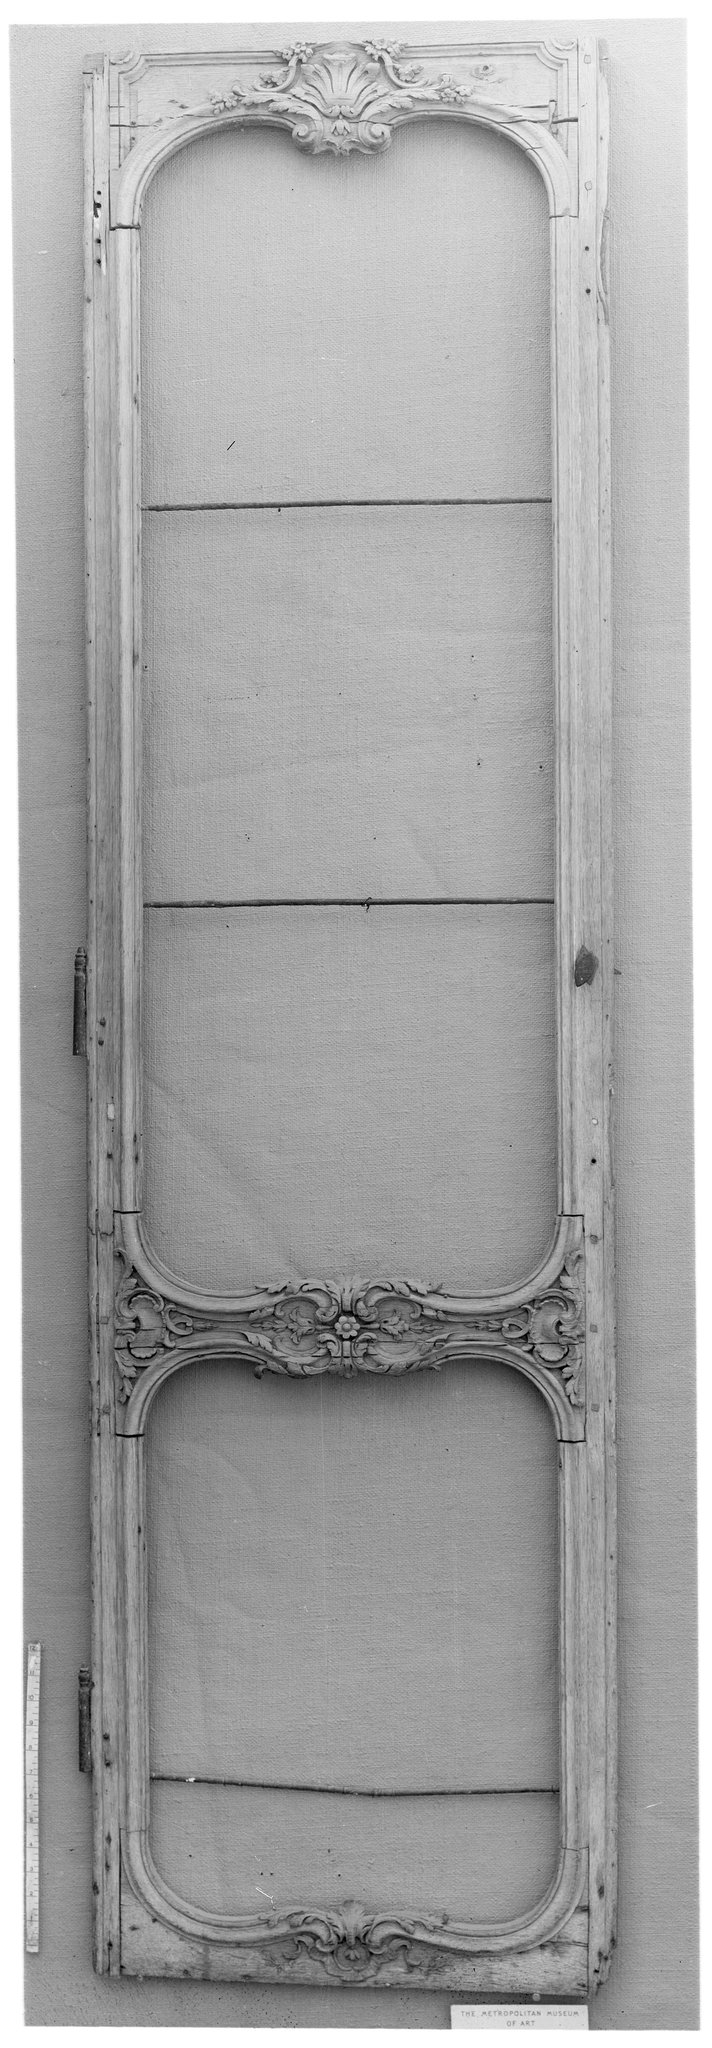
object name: bookcase door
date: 1701-1800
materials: wood